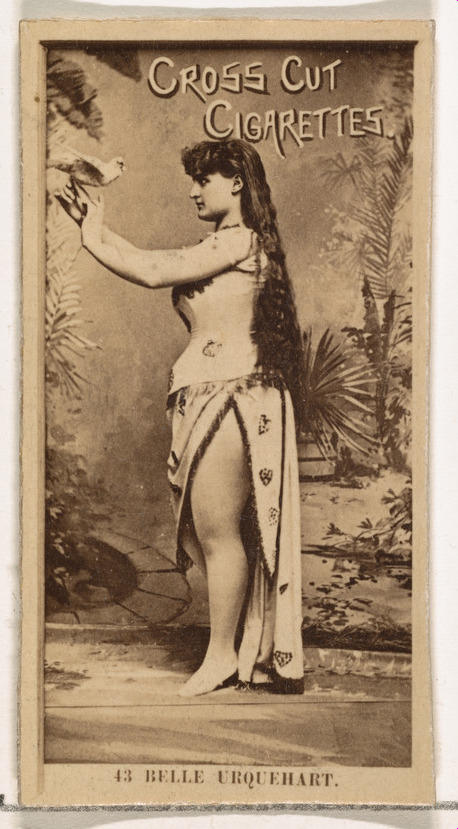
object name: print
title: Card Number 43, Belle Urquehart, from the Actors and Actresses series (N145-2) issued by Duke Sons & Co. to promote Cross Cut Cigarettes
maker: w. duke, sons & co.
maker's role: publisher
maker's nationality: american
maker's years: 1870-1920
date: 1880-1889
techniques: albumen silver print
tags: women,actresses